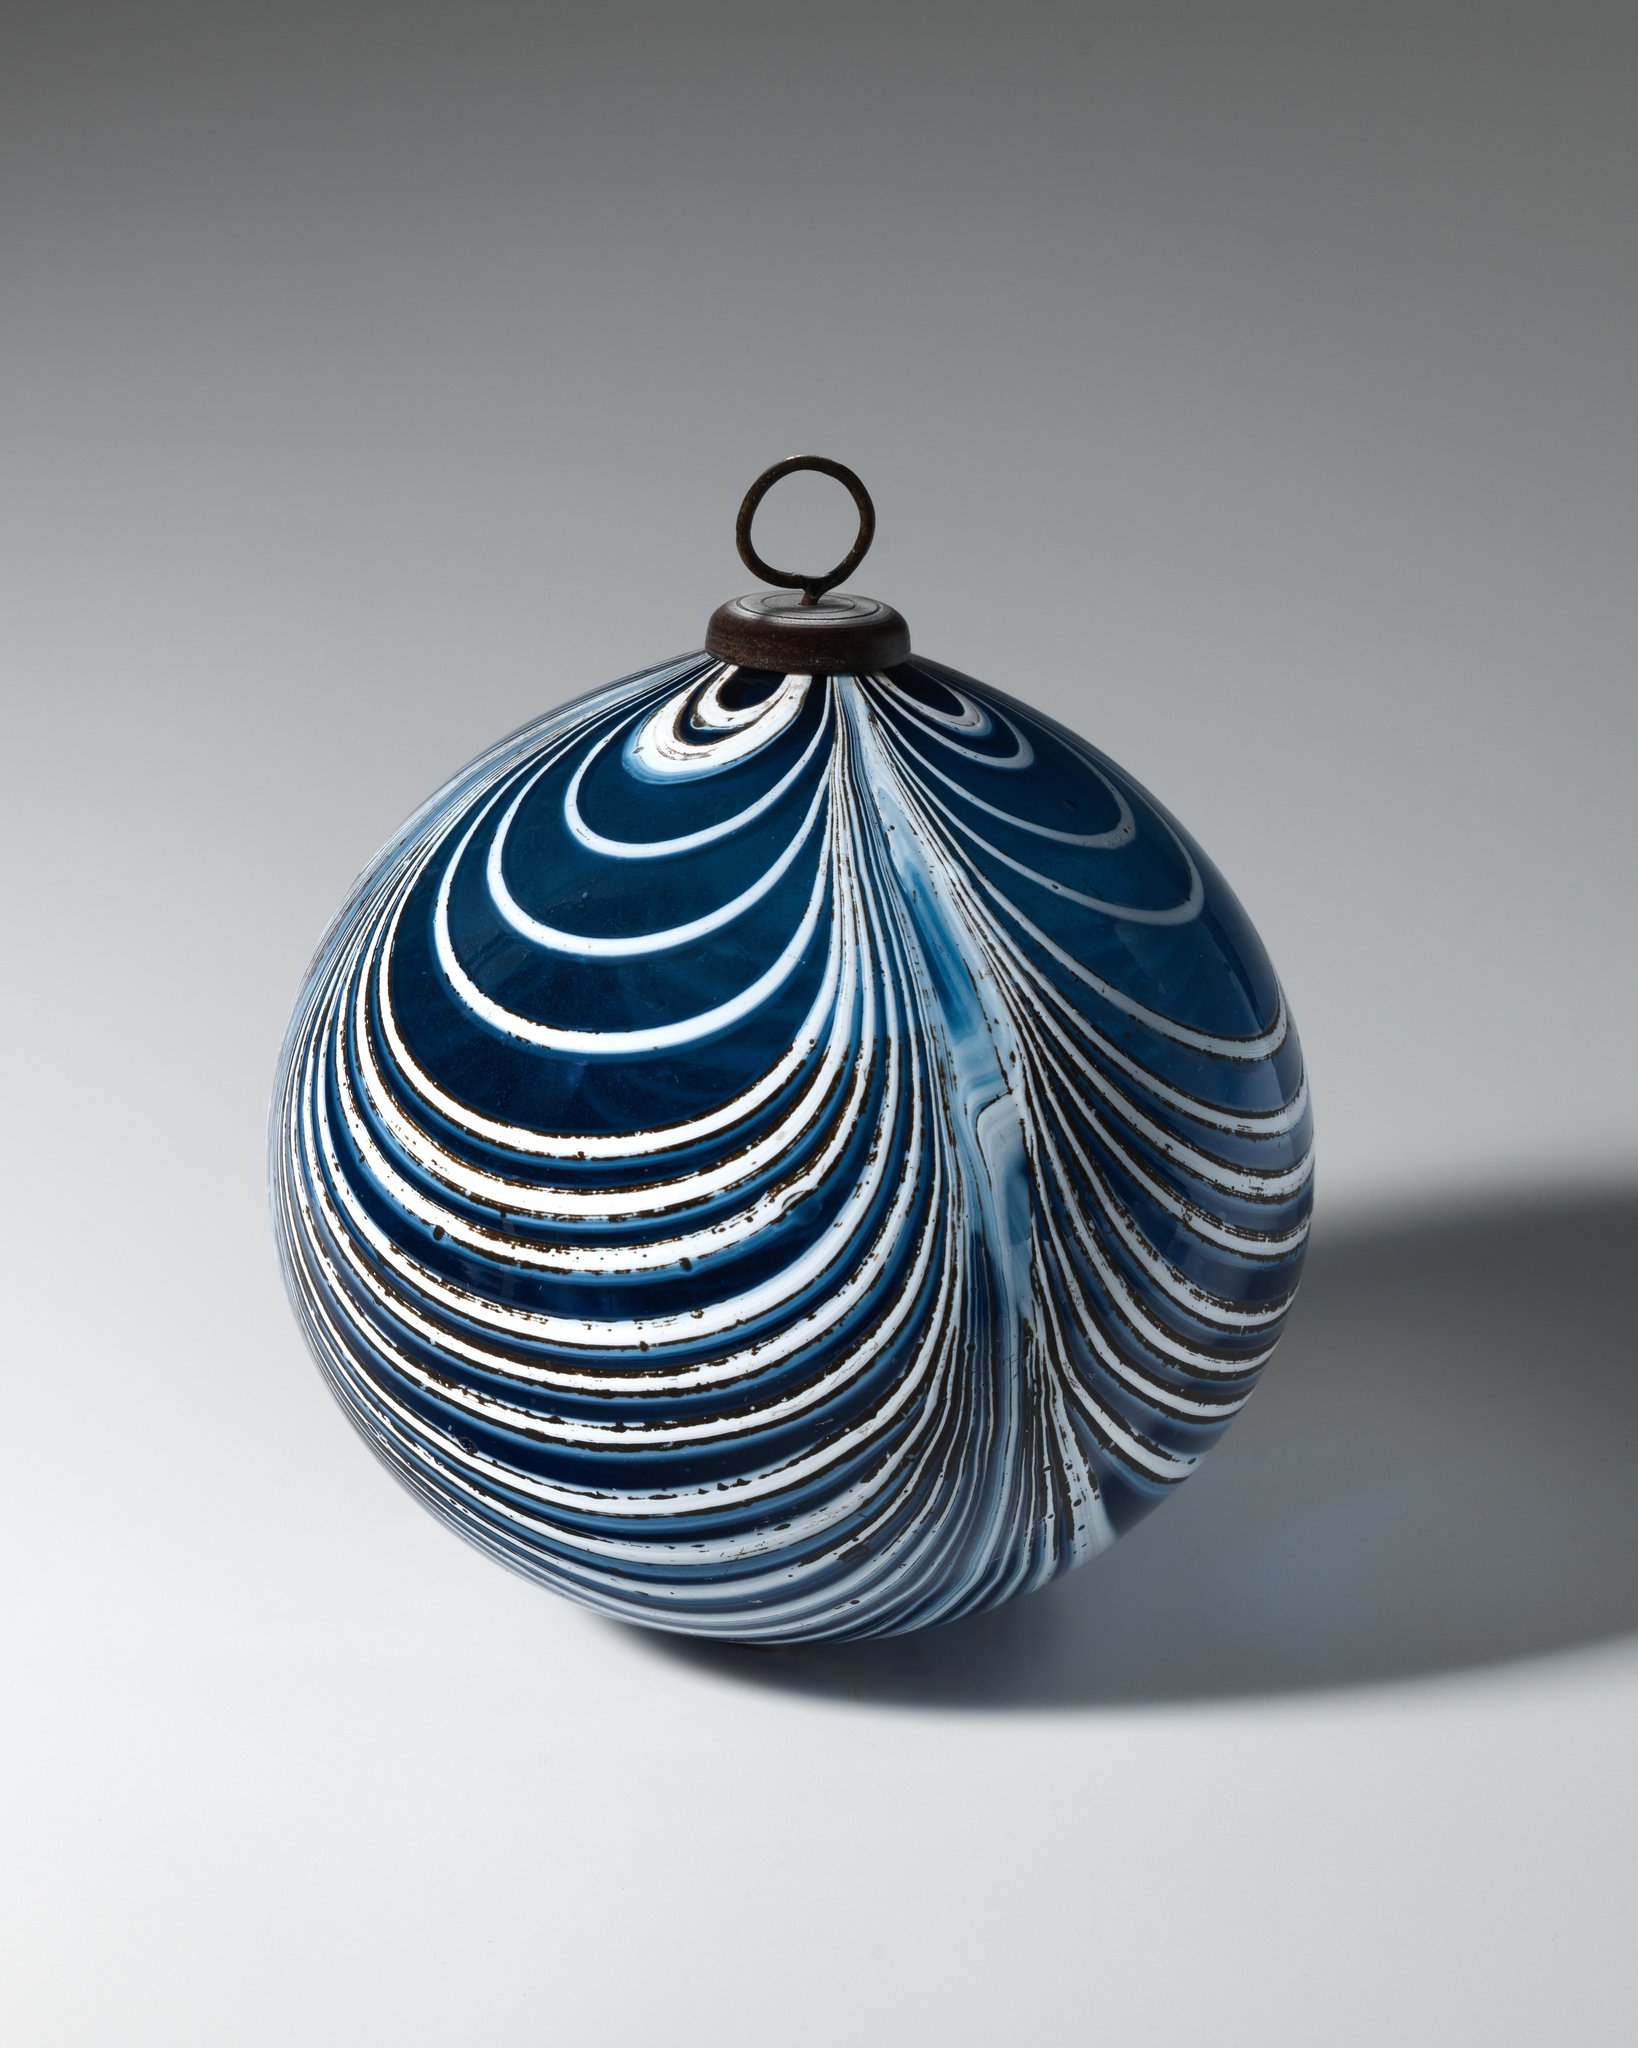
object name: ball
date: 1701-1900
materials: copper, glass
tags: sports